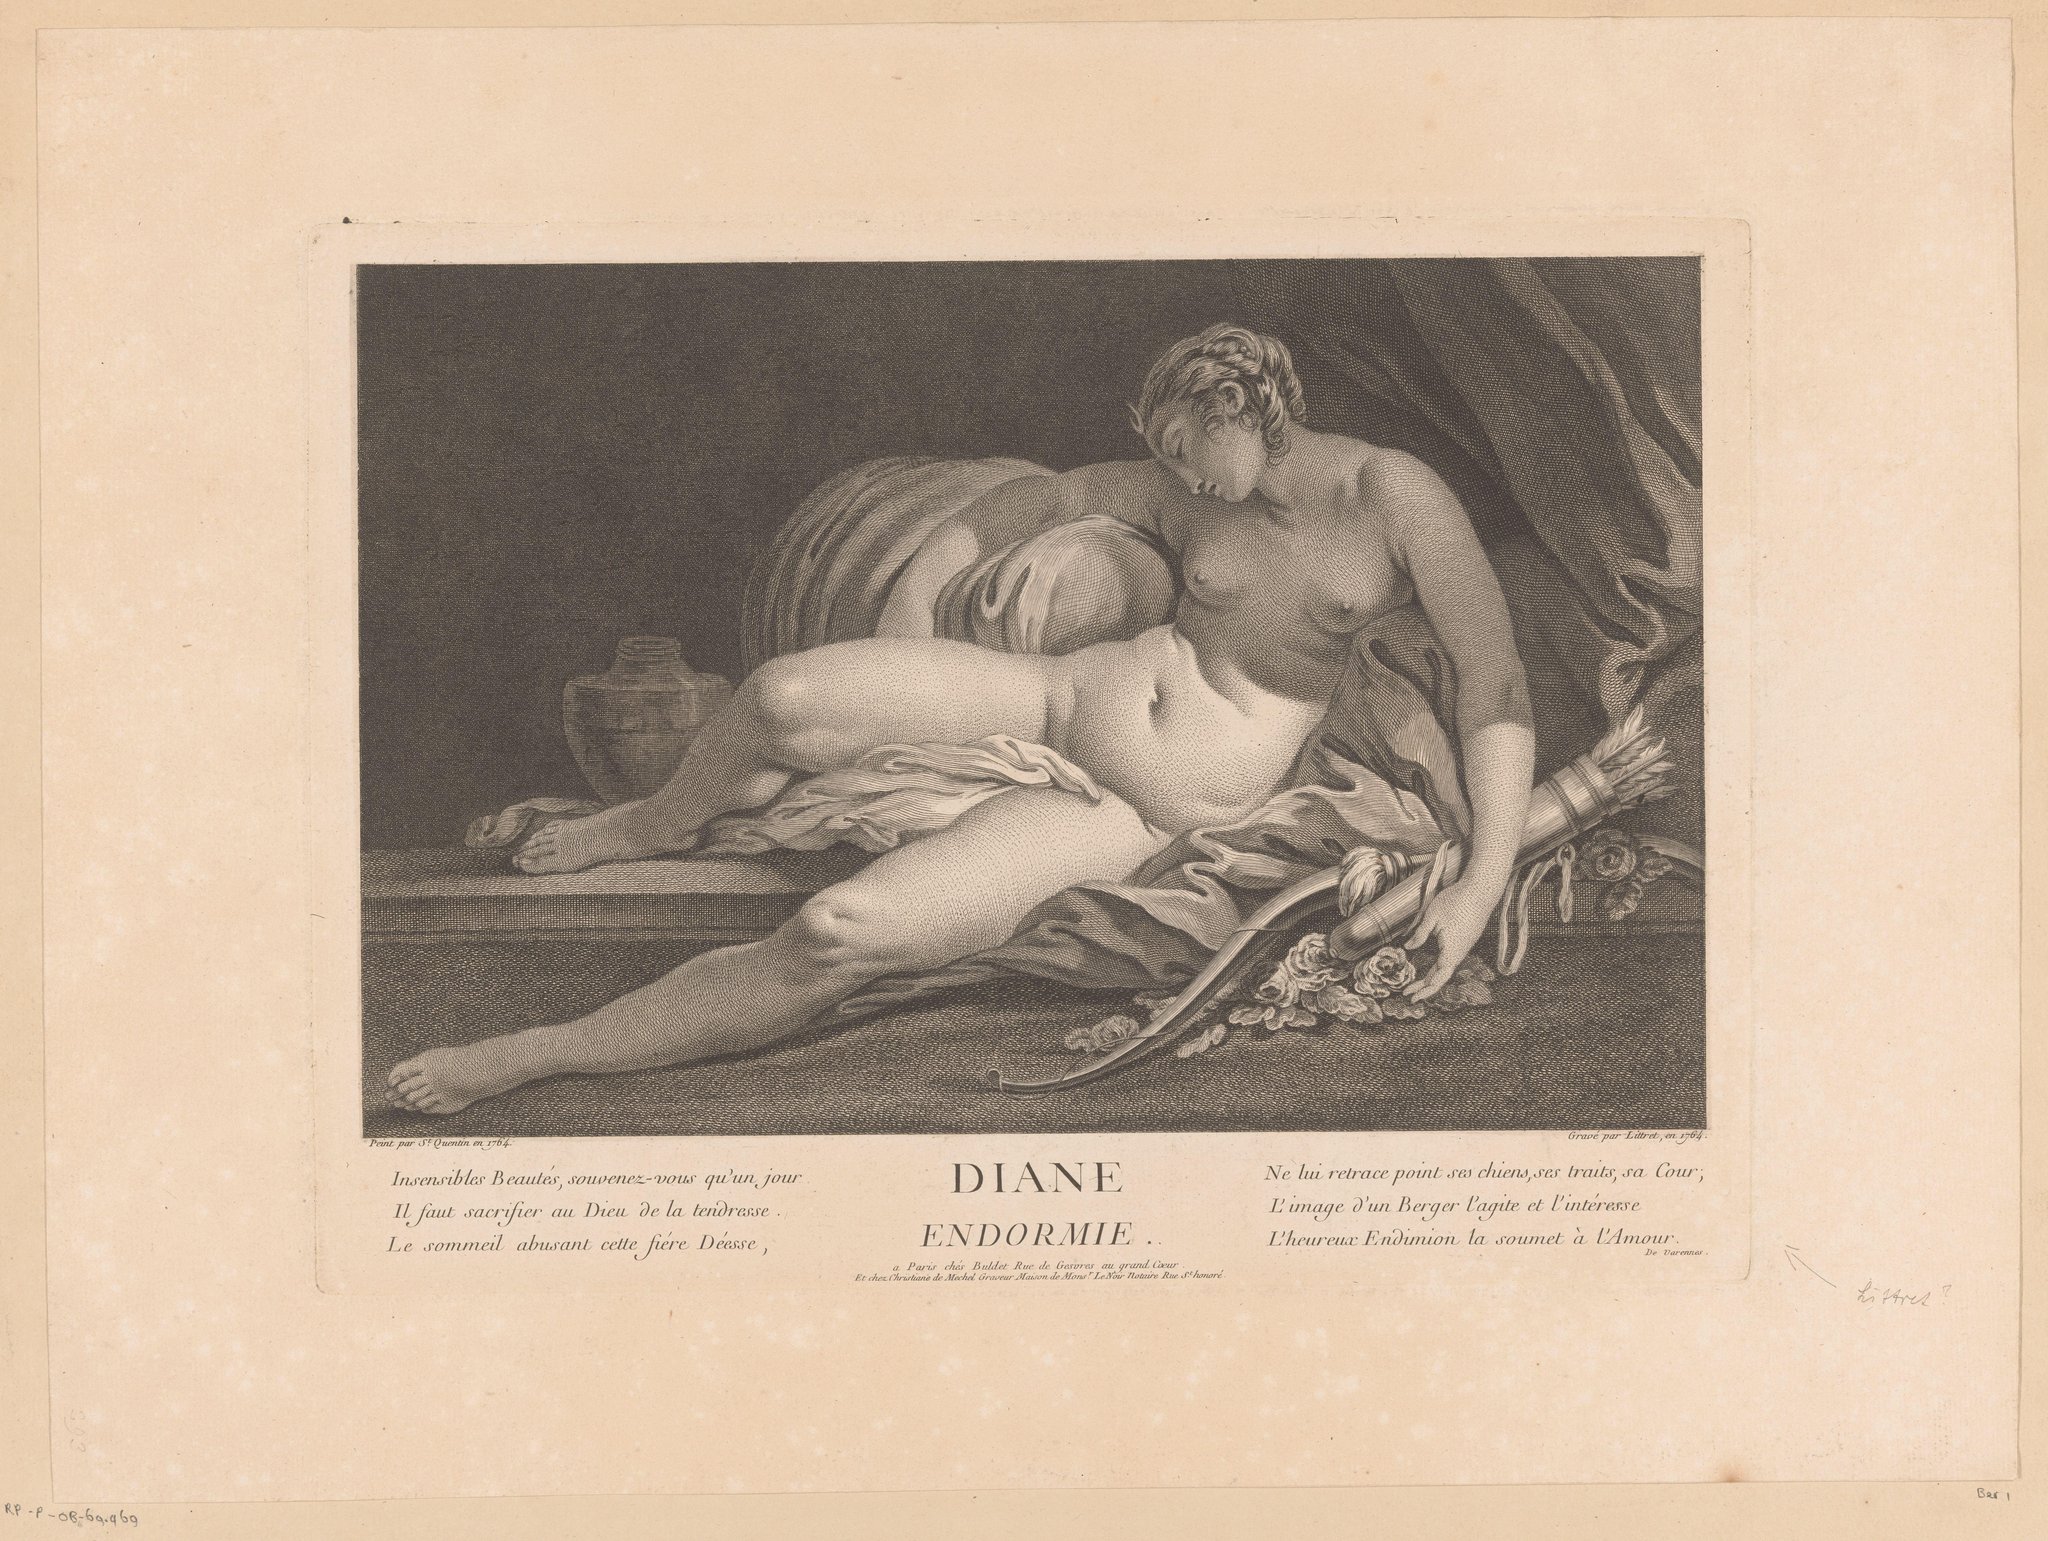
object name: print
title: Slapende Diana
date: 1764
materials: paper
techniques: engraving, etching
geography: paris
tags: non-aggressive, friendly or neutral activities and relationships of diana, sleeping; unconsciousness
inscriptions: watermark, collector's mark: Lugt 240